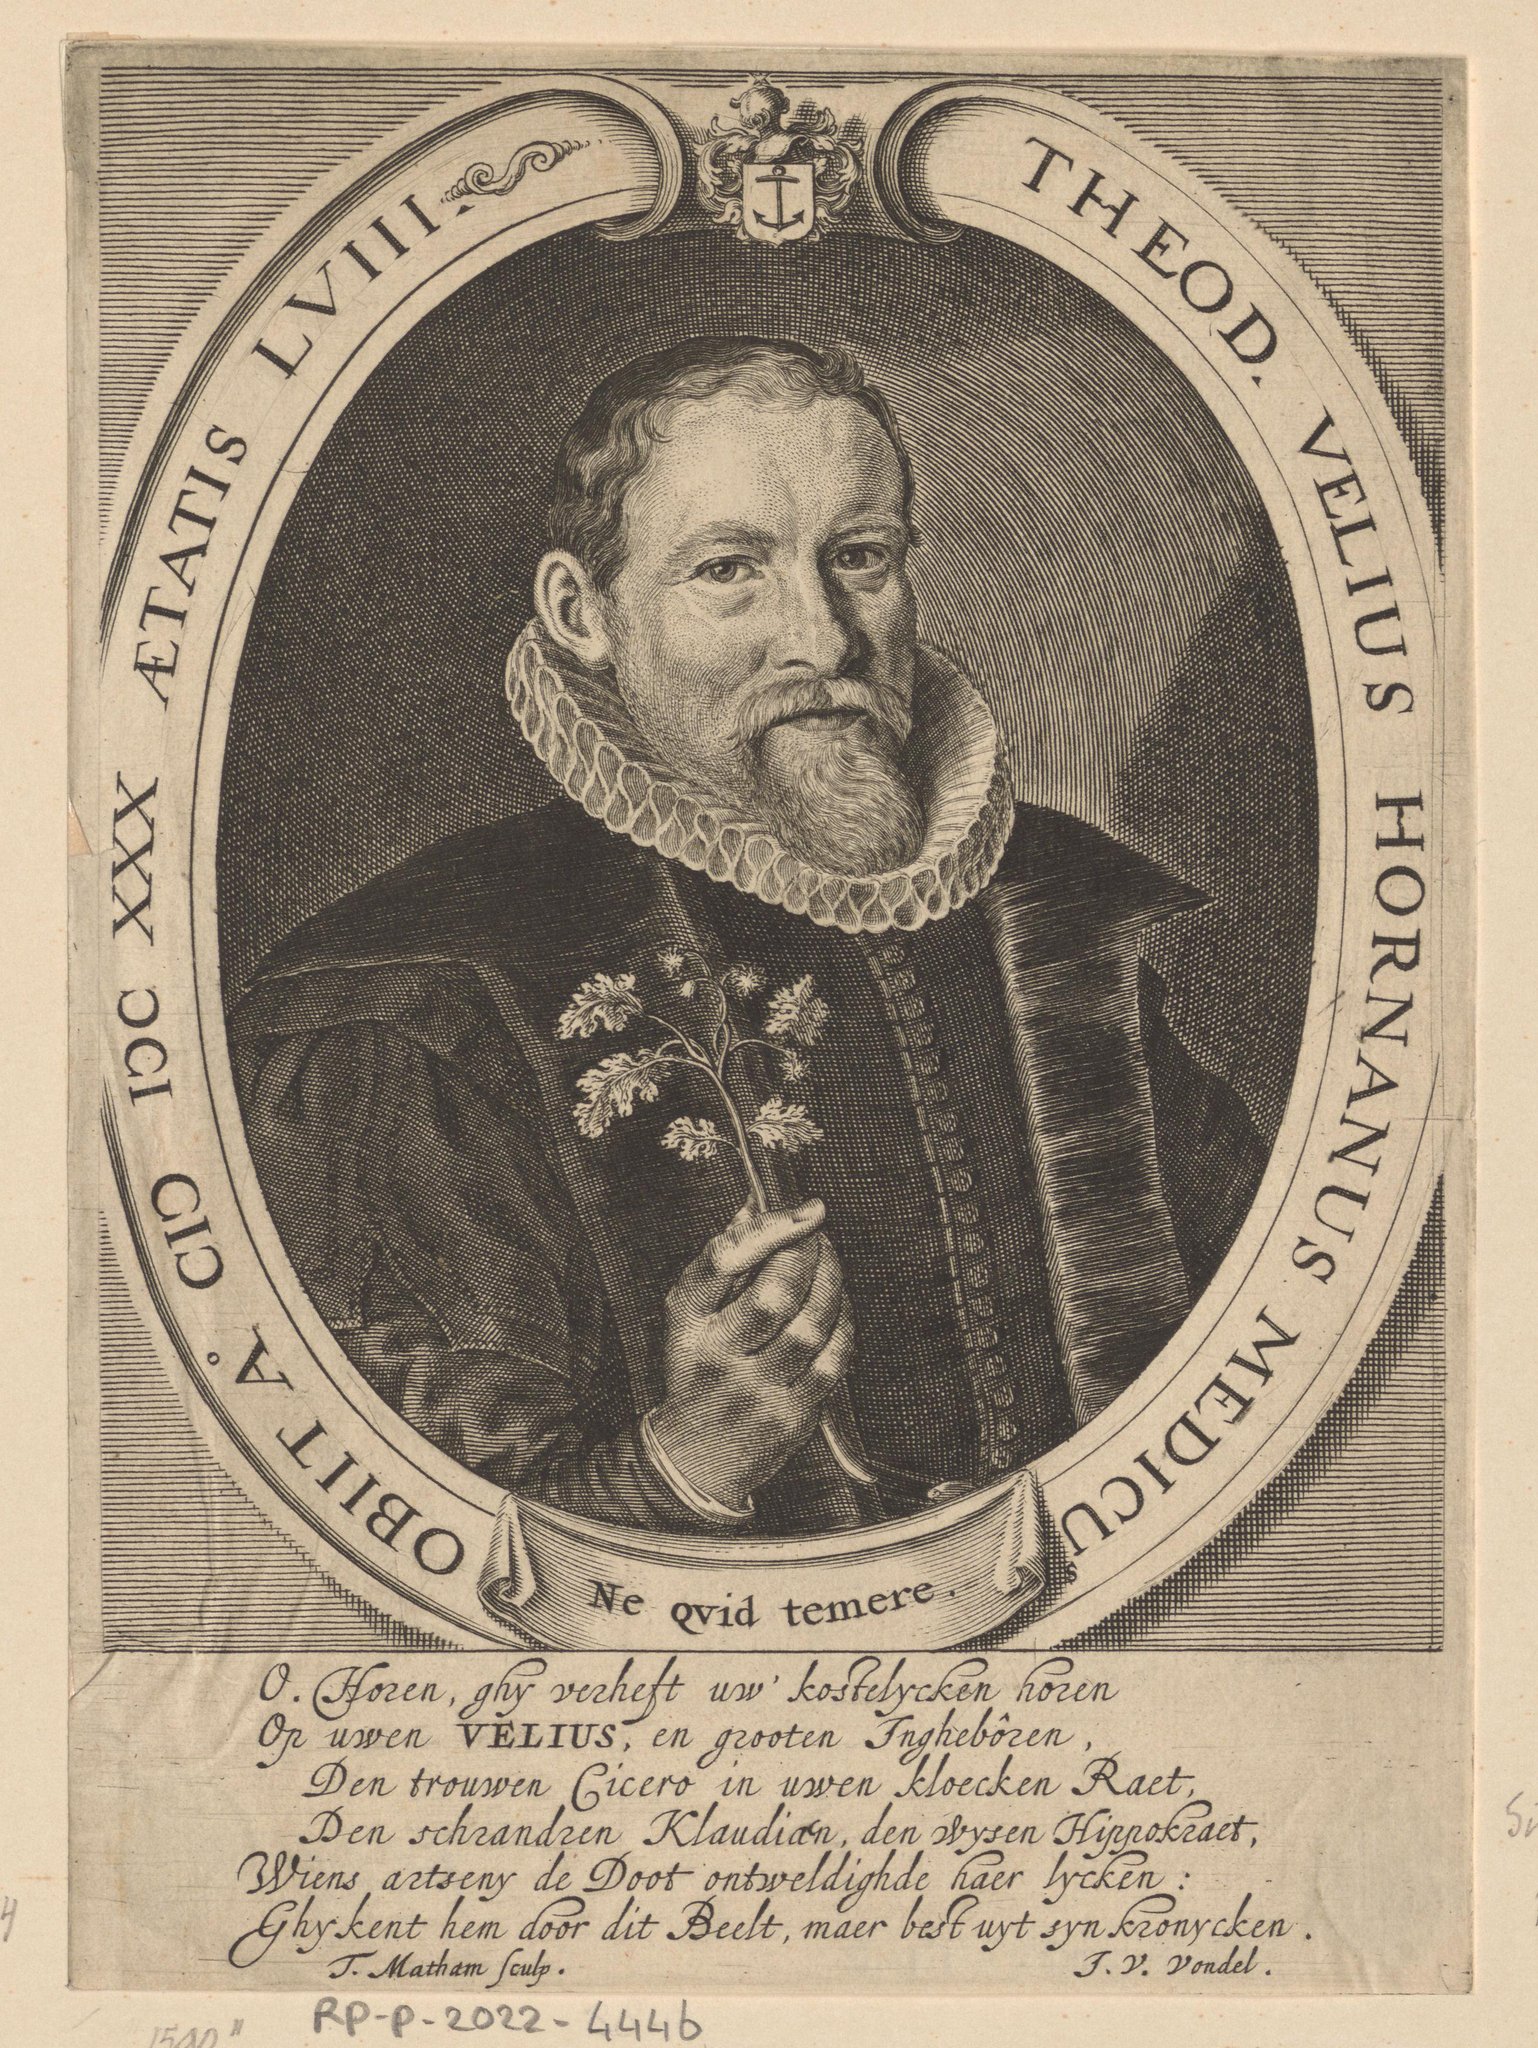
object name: print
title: Portret van Theodorus Velius op 58-jarige leeftijd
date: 1630-1676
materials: paper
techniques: engraving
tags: hoorn (north holland), theodorus velius, historical persons, portrait of a writer, armorial bearing, heraldry, plants and herbs: thistle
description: Onder het portret een zesregelig vers in het Nederlands.